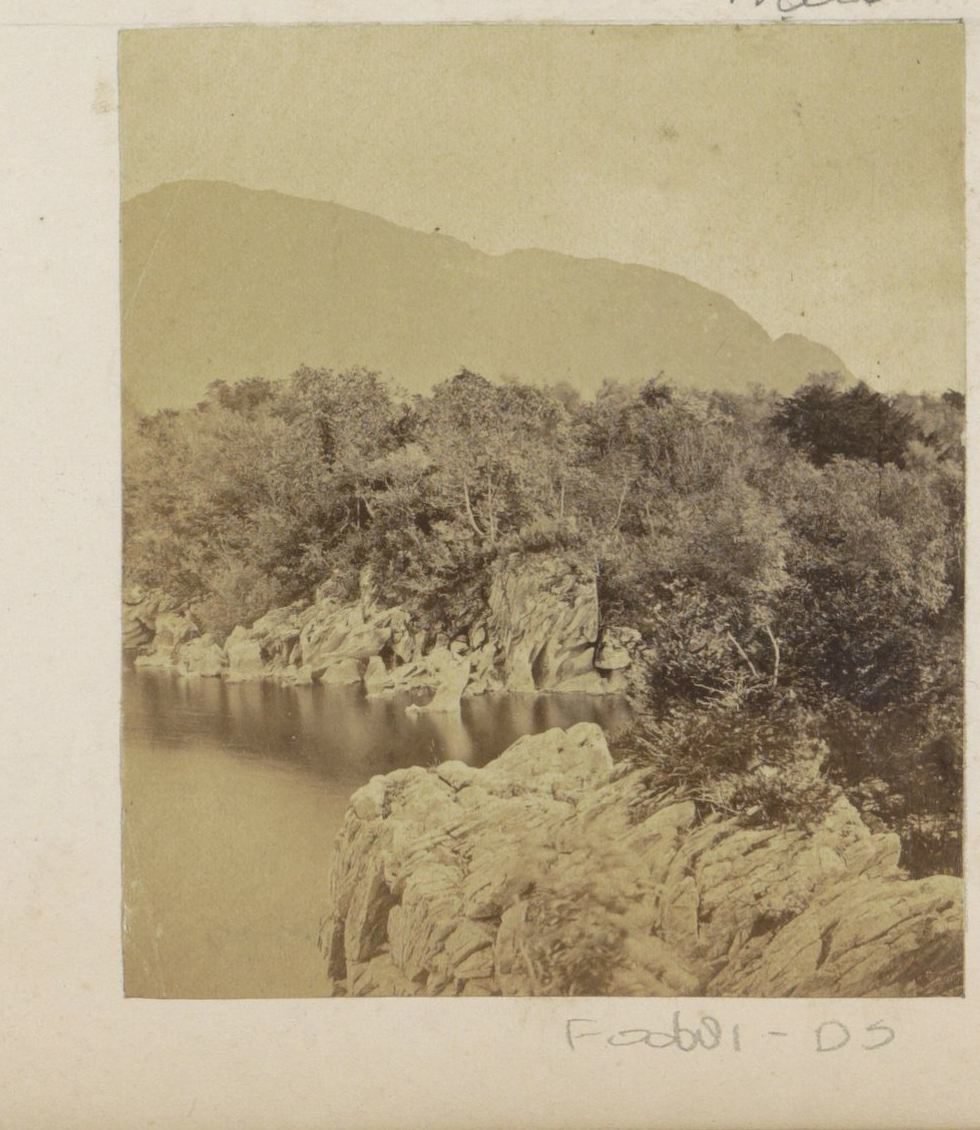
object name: photograph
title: Rivierlandschap, vermoedelijk in Engeland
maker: Anonymous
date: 1850-1870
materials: paper, photographic support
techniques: albumen print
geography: england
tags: landscapes with waters, waterscapes, seascapes (in the temperate zone) (+ landscape with figures, staffage), england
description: Onderdeel van Album met foto's van bezienswaardigheden en landschappen in Engeland en van kunst.